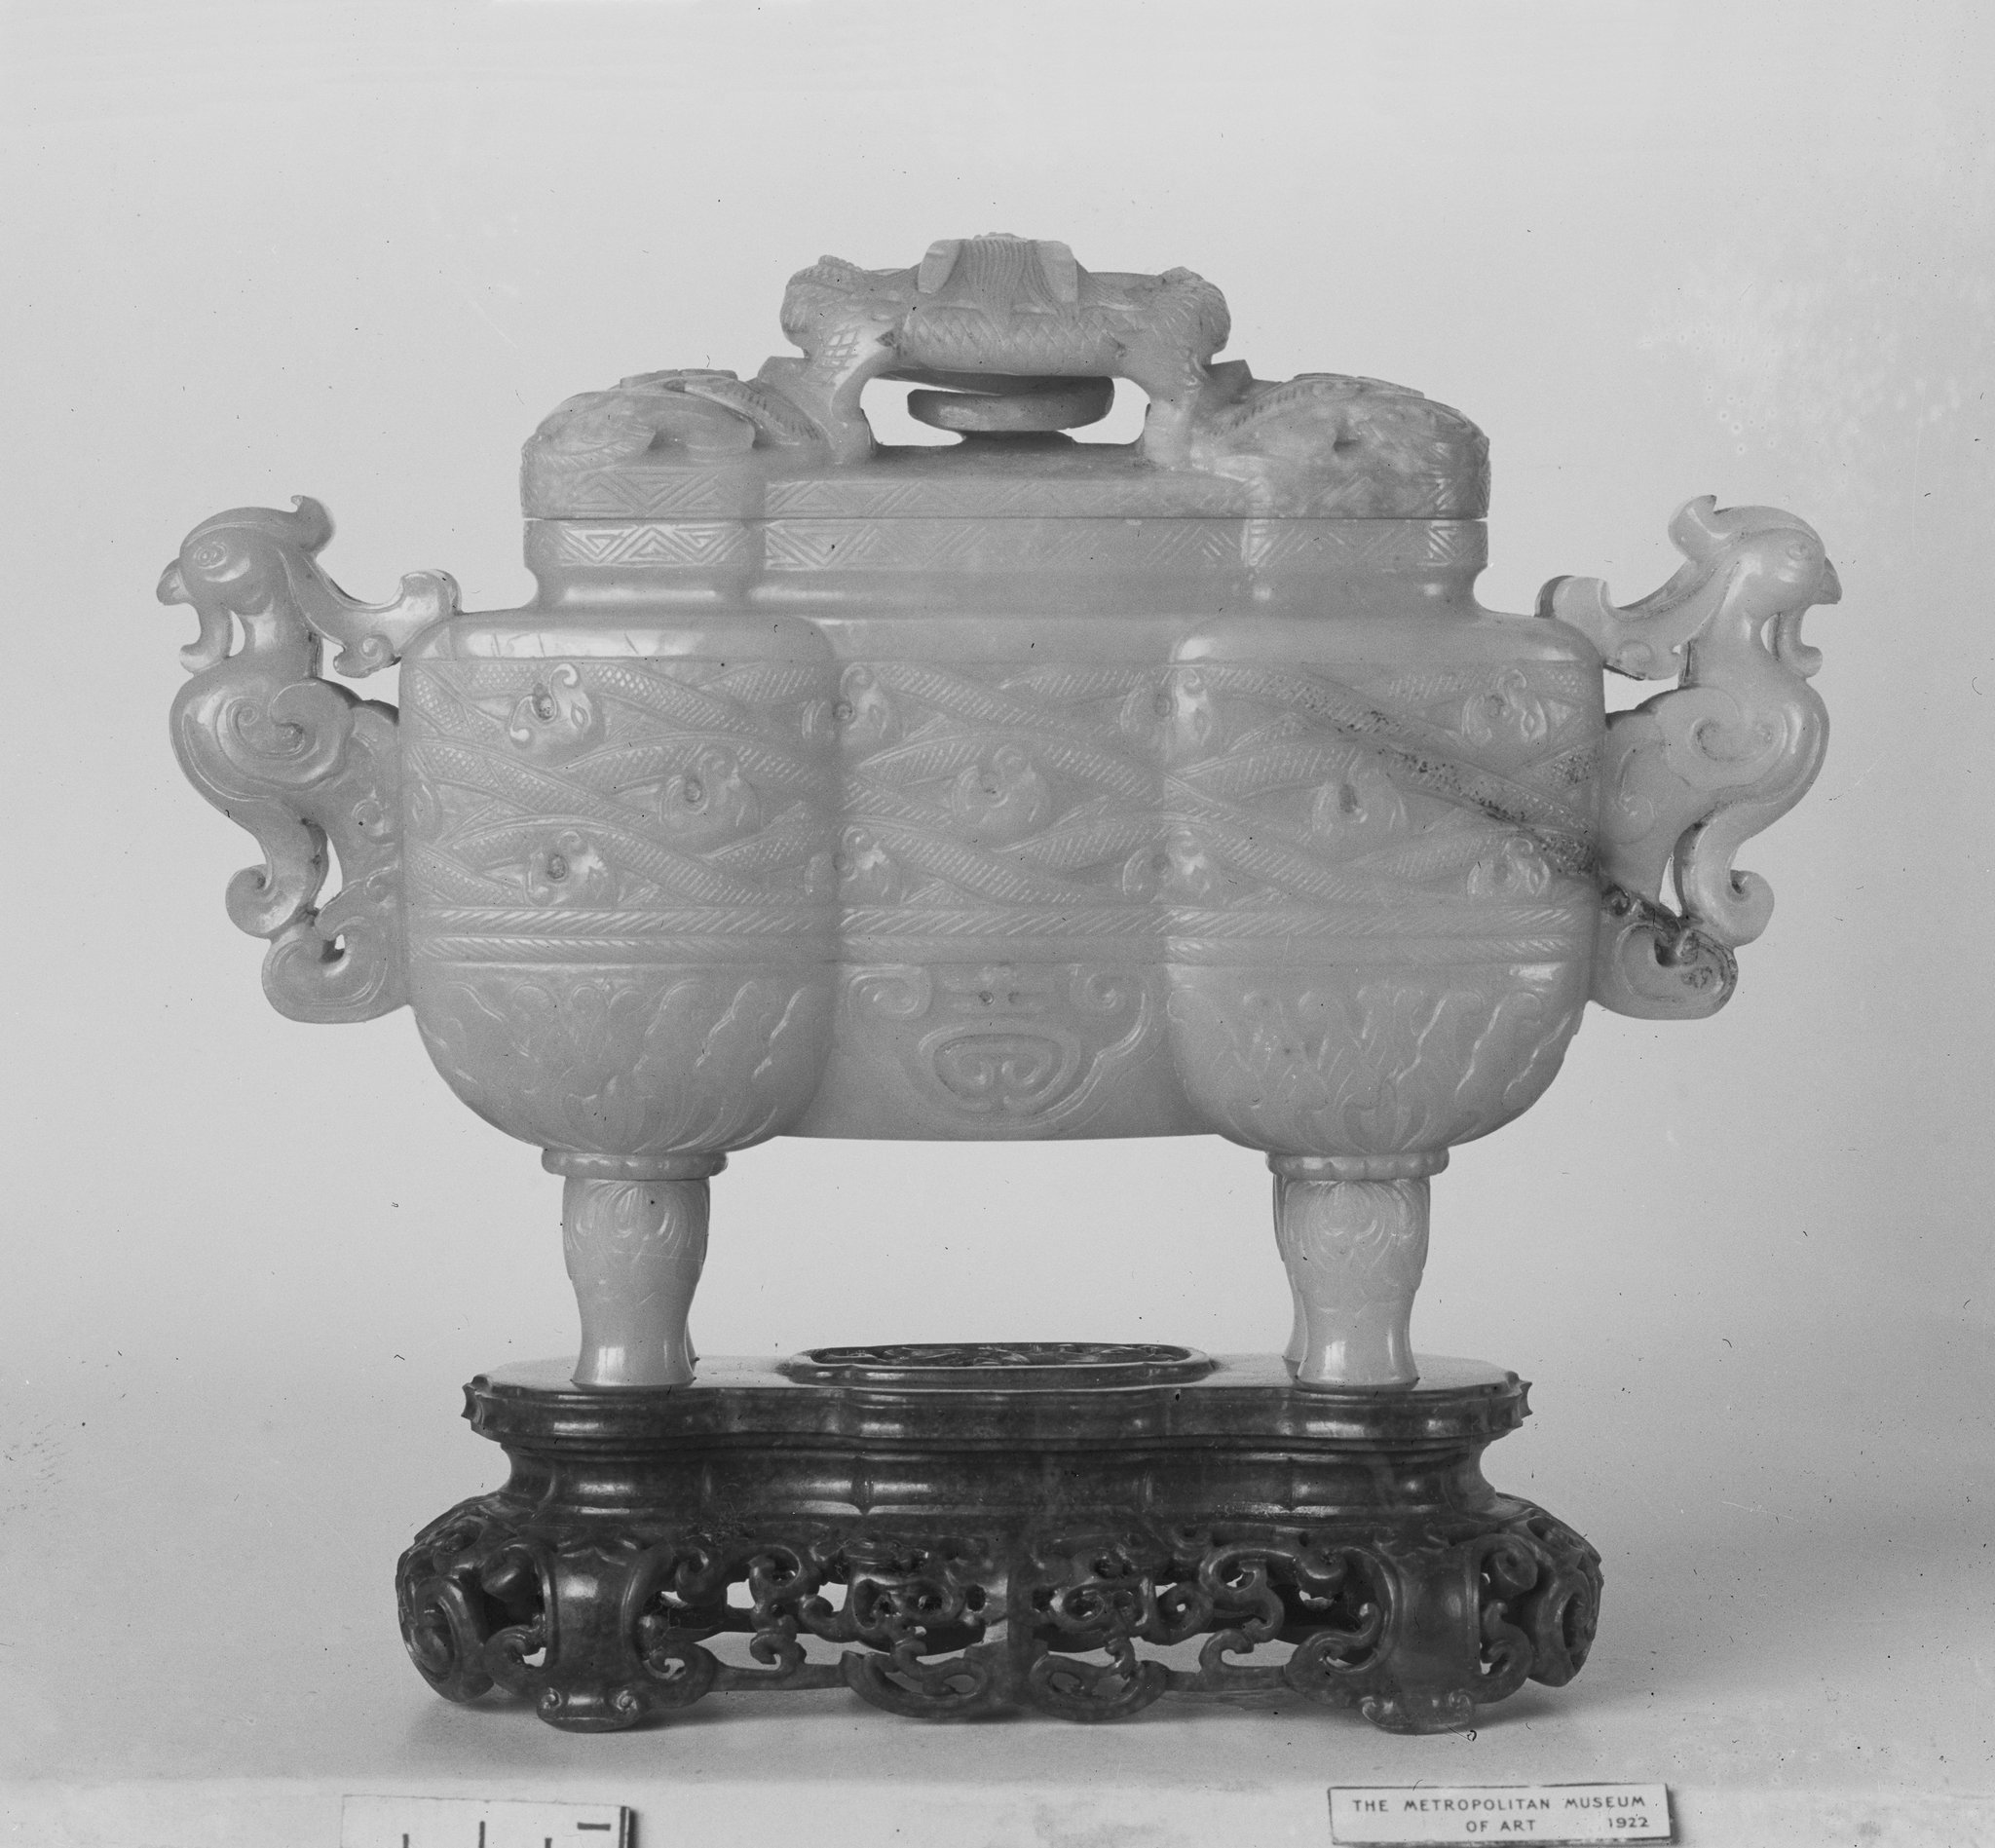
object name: incense utensil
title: Incense Burner on Stand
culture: chinese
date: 1767-1833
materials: jade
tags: birds